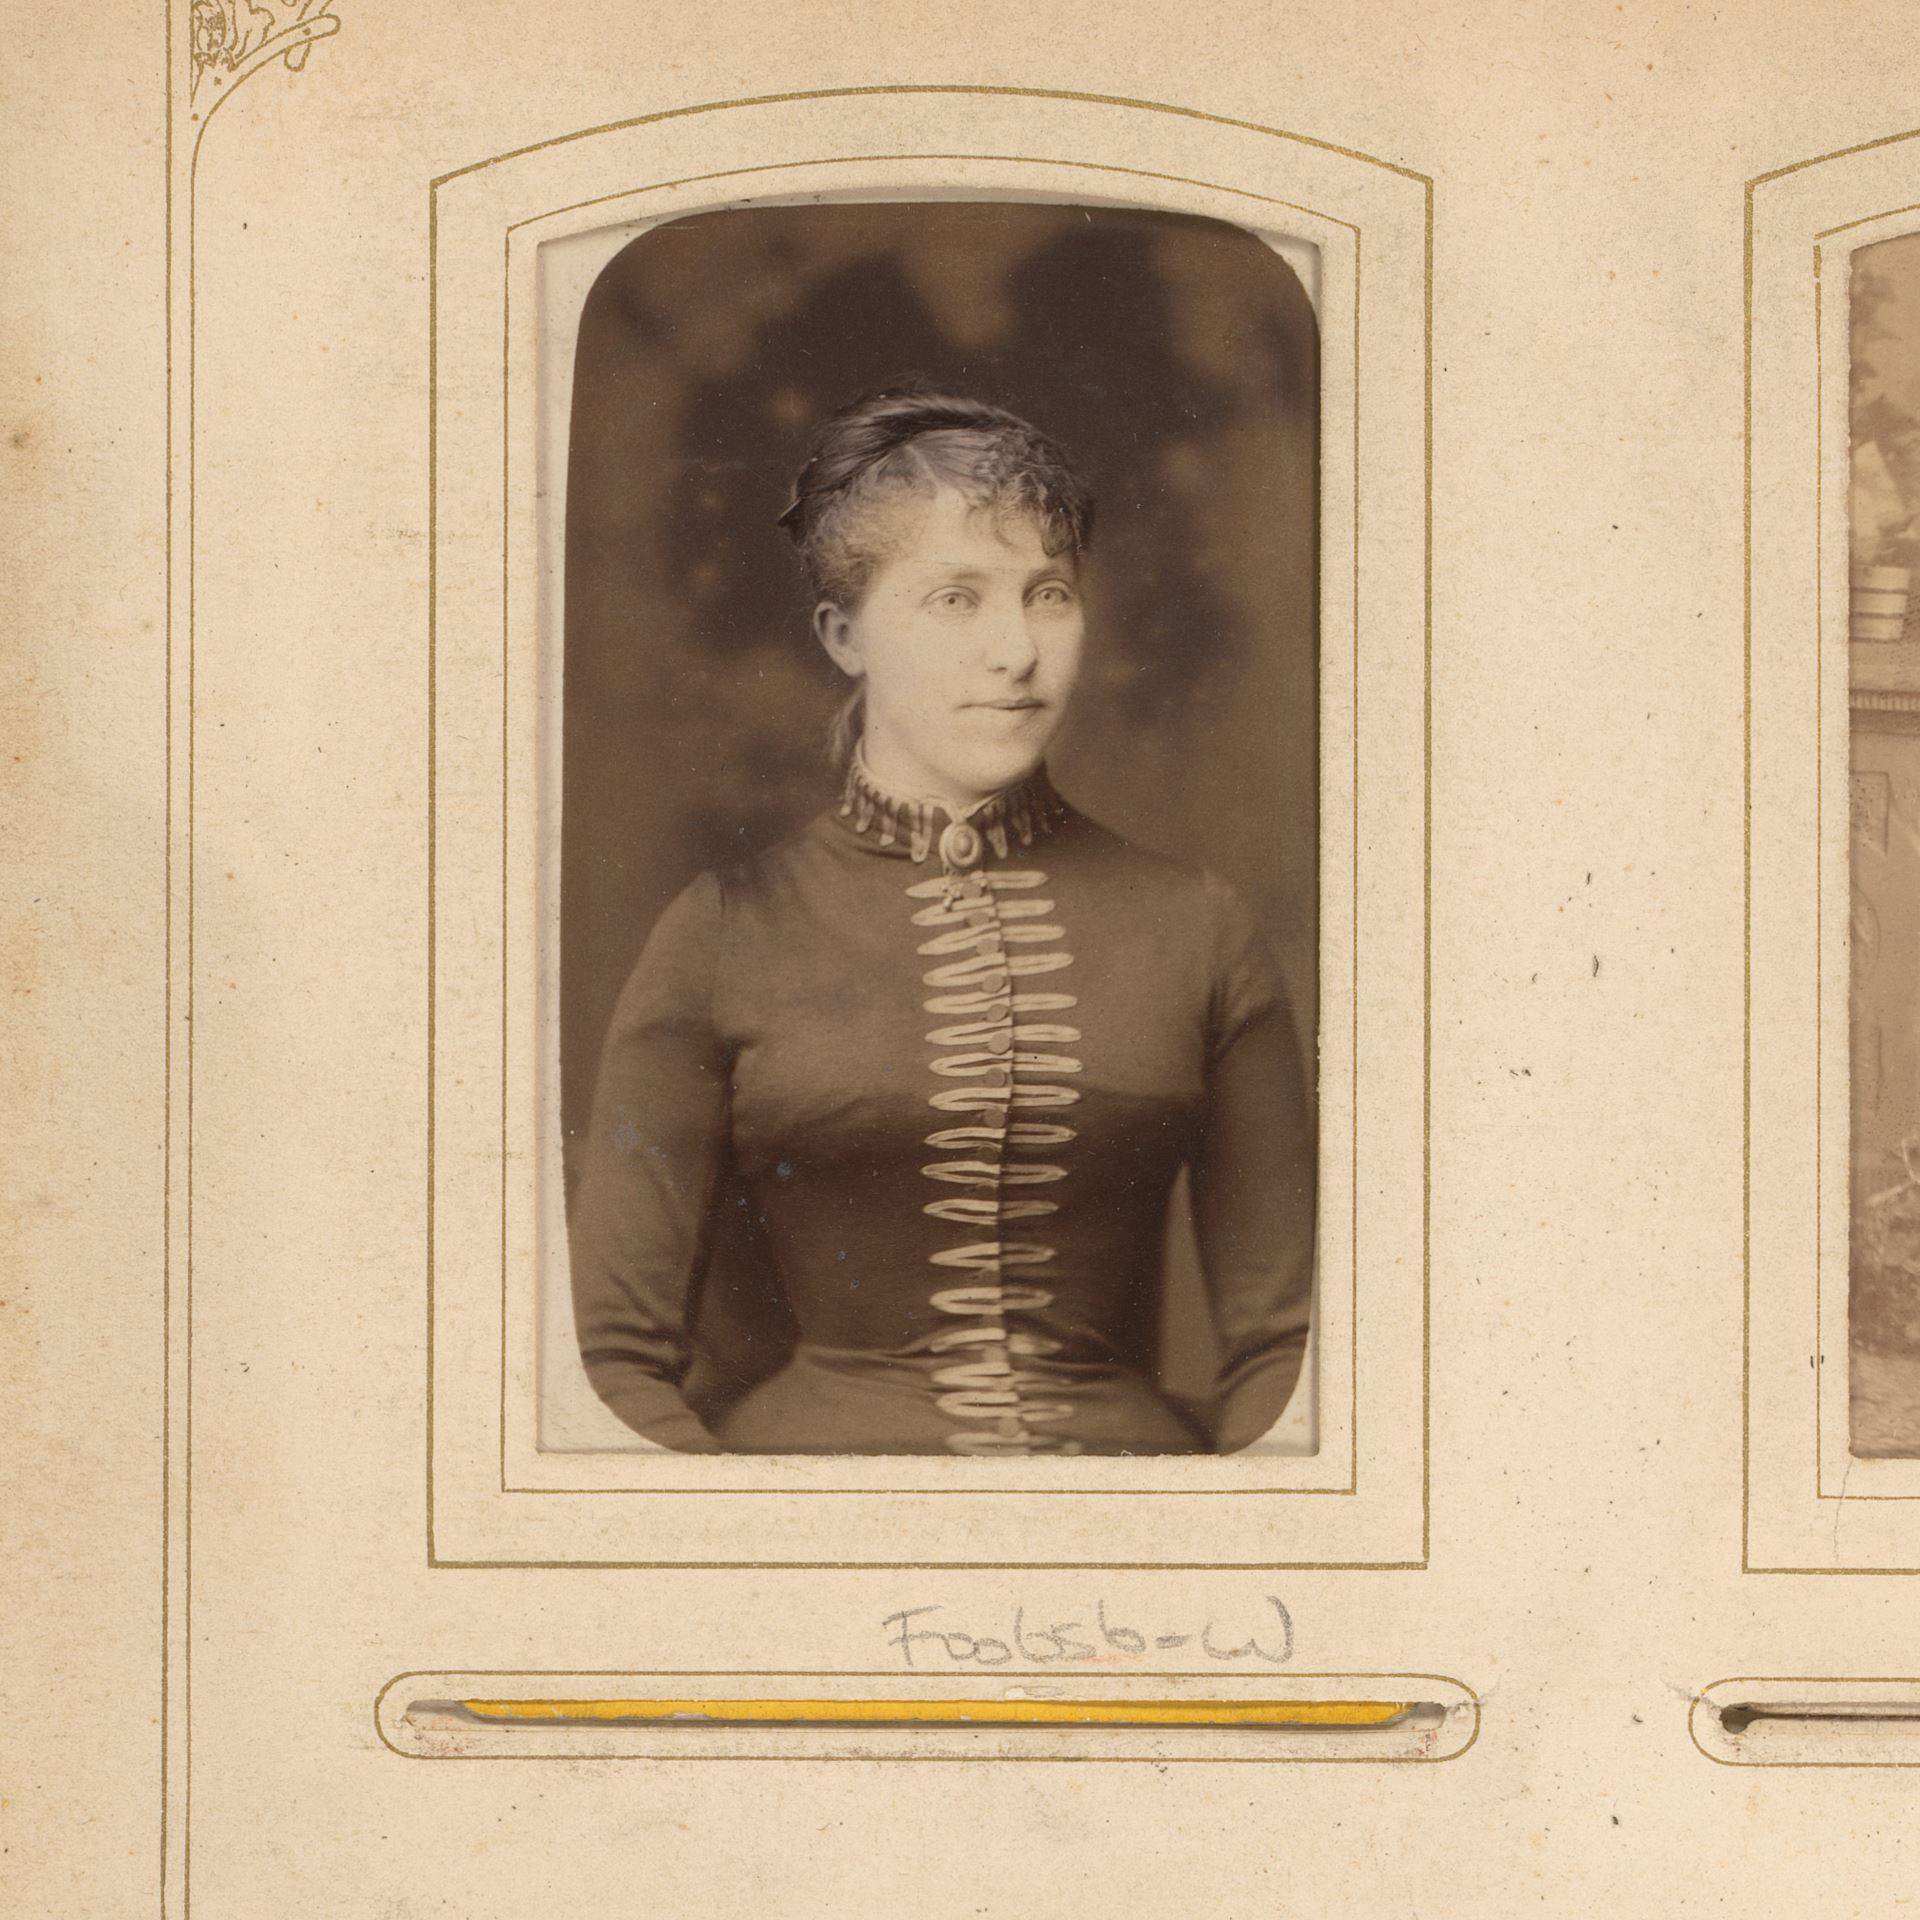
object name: photograph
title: Portret van een vrouw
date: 1875-1899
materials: cardboard, photographic support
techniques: albumen print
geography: ghent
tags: historical persons - bb - woman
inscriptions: inscription: ‘Photographie perfectionnée/ GRANDS PORTRAITS & REPRODUCTIONS/ Maison unique/ RUE DE LA CORNE, 1/ GAND/ 12 Portraits émaillés frs. 6.50’